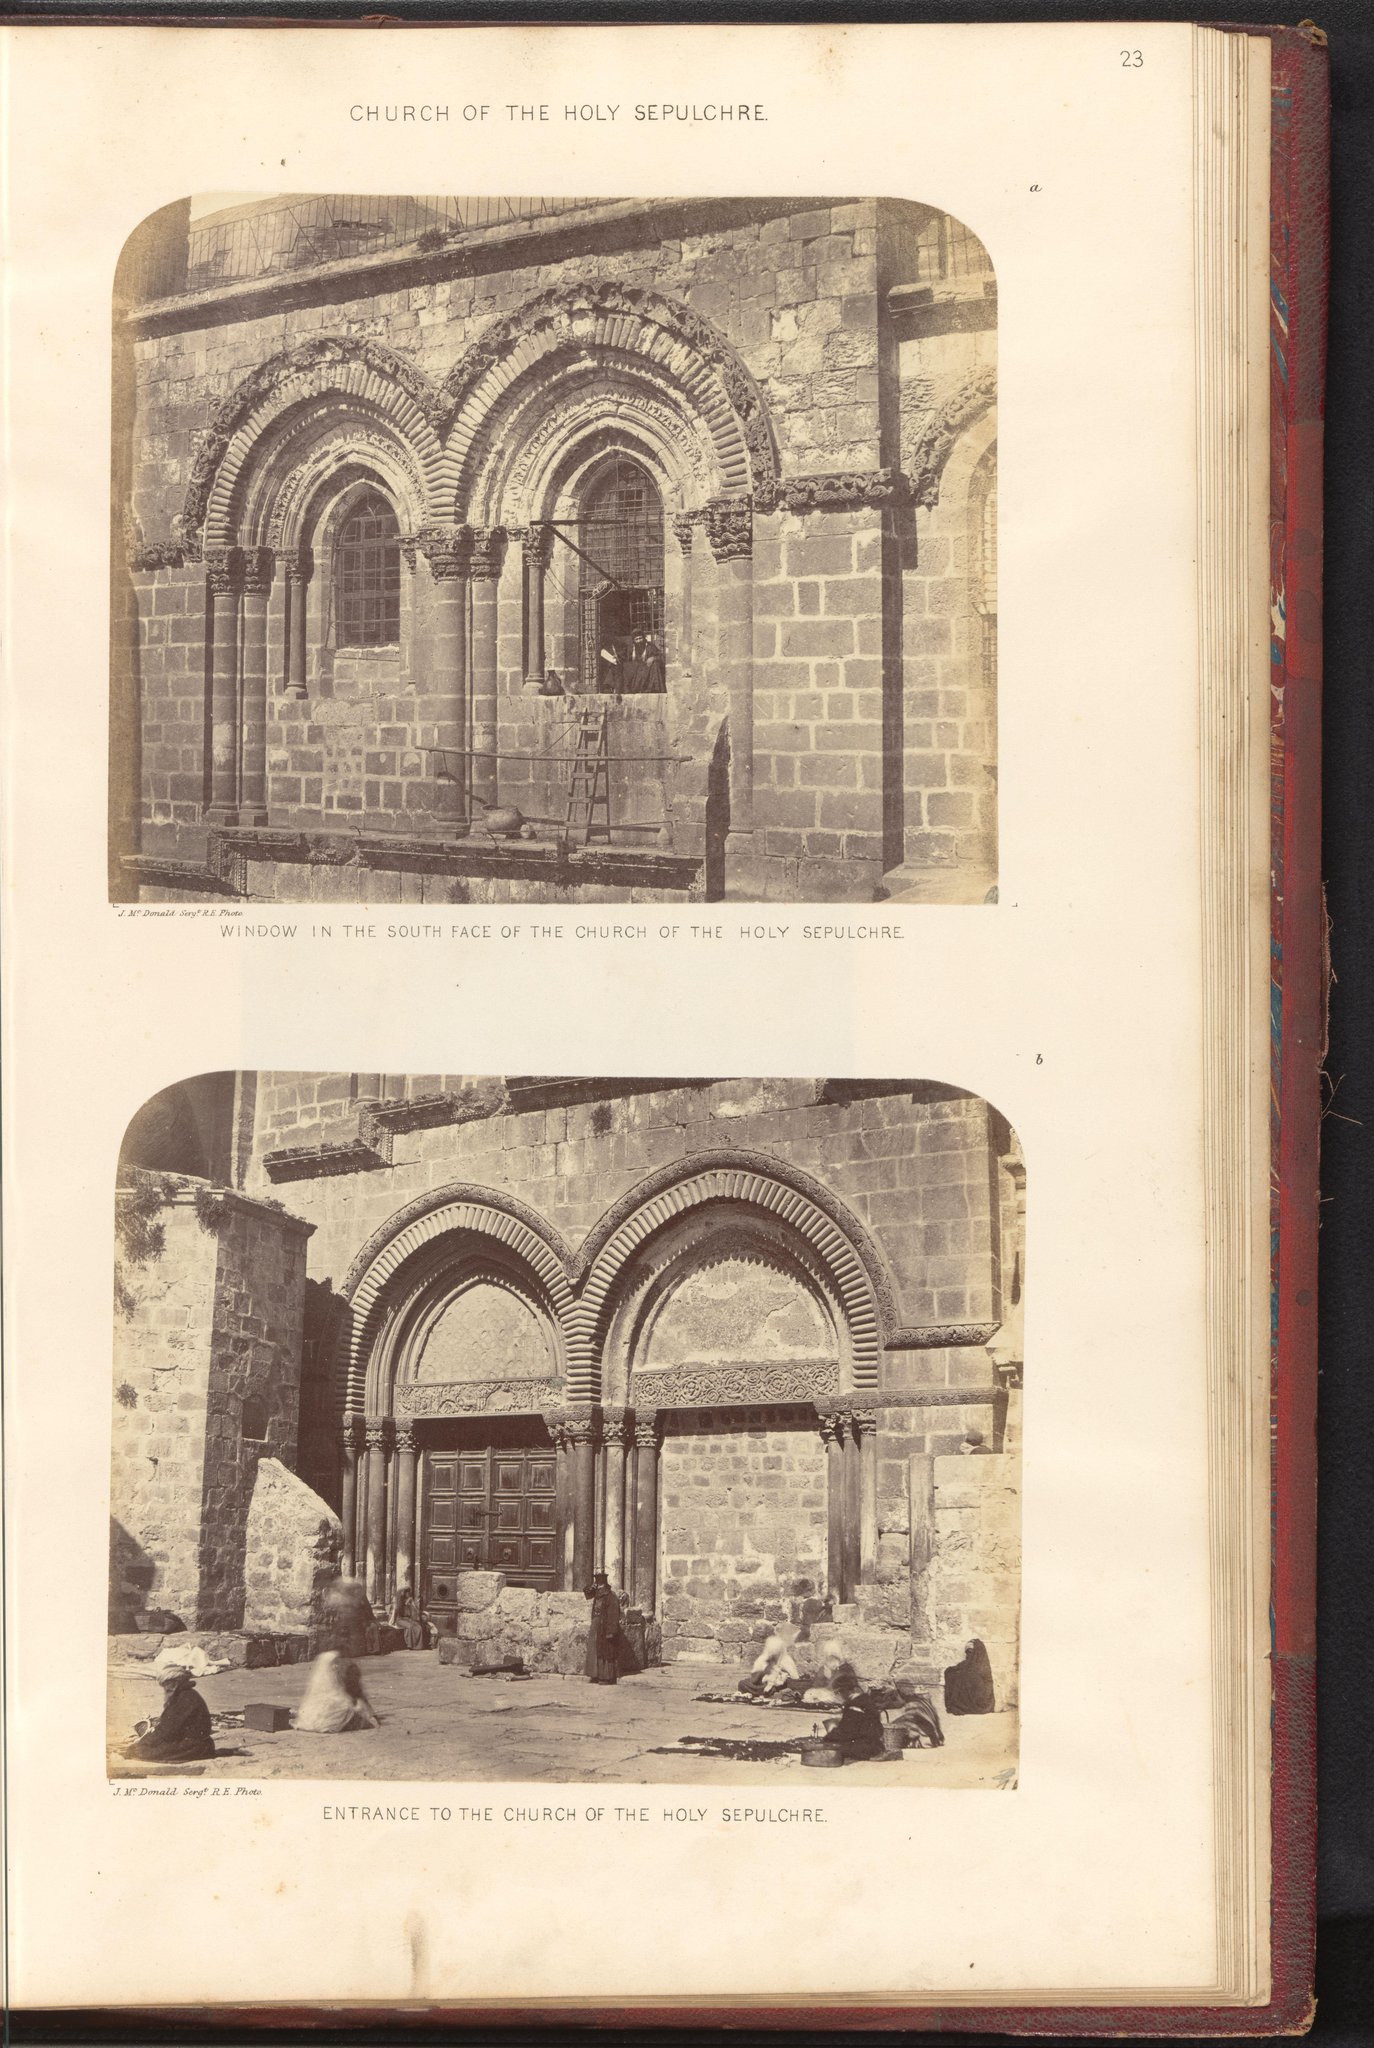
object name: page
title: Window in the South Face of the Church of the Holy Sepulchre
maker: james mcdonald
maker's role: fotograaf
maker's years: 1822-1885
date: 1860-1865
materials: paper, photographic support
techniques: albumen print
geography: jerusalem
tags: church (exterior), gate, entrance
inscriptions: inscription: ‘a’, inscription: ‘b’